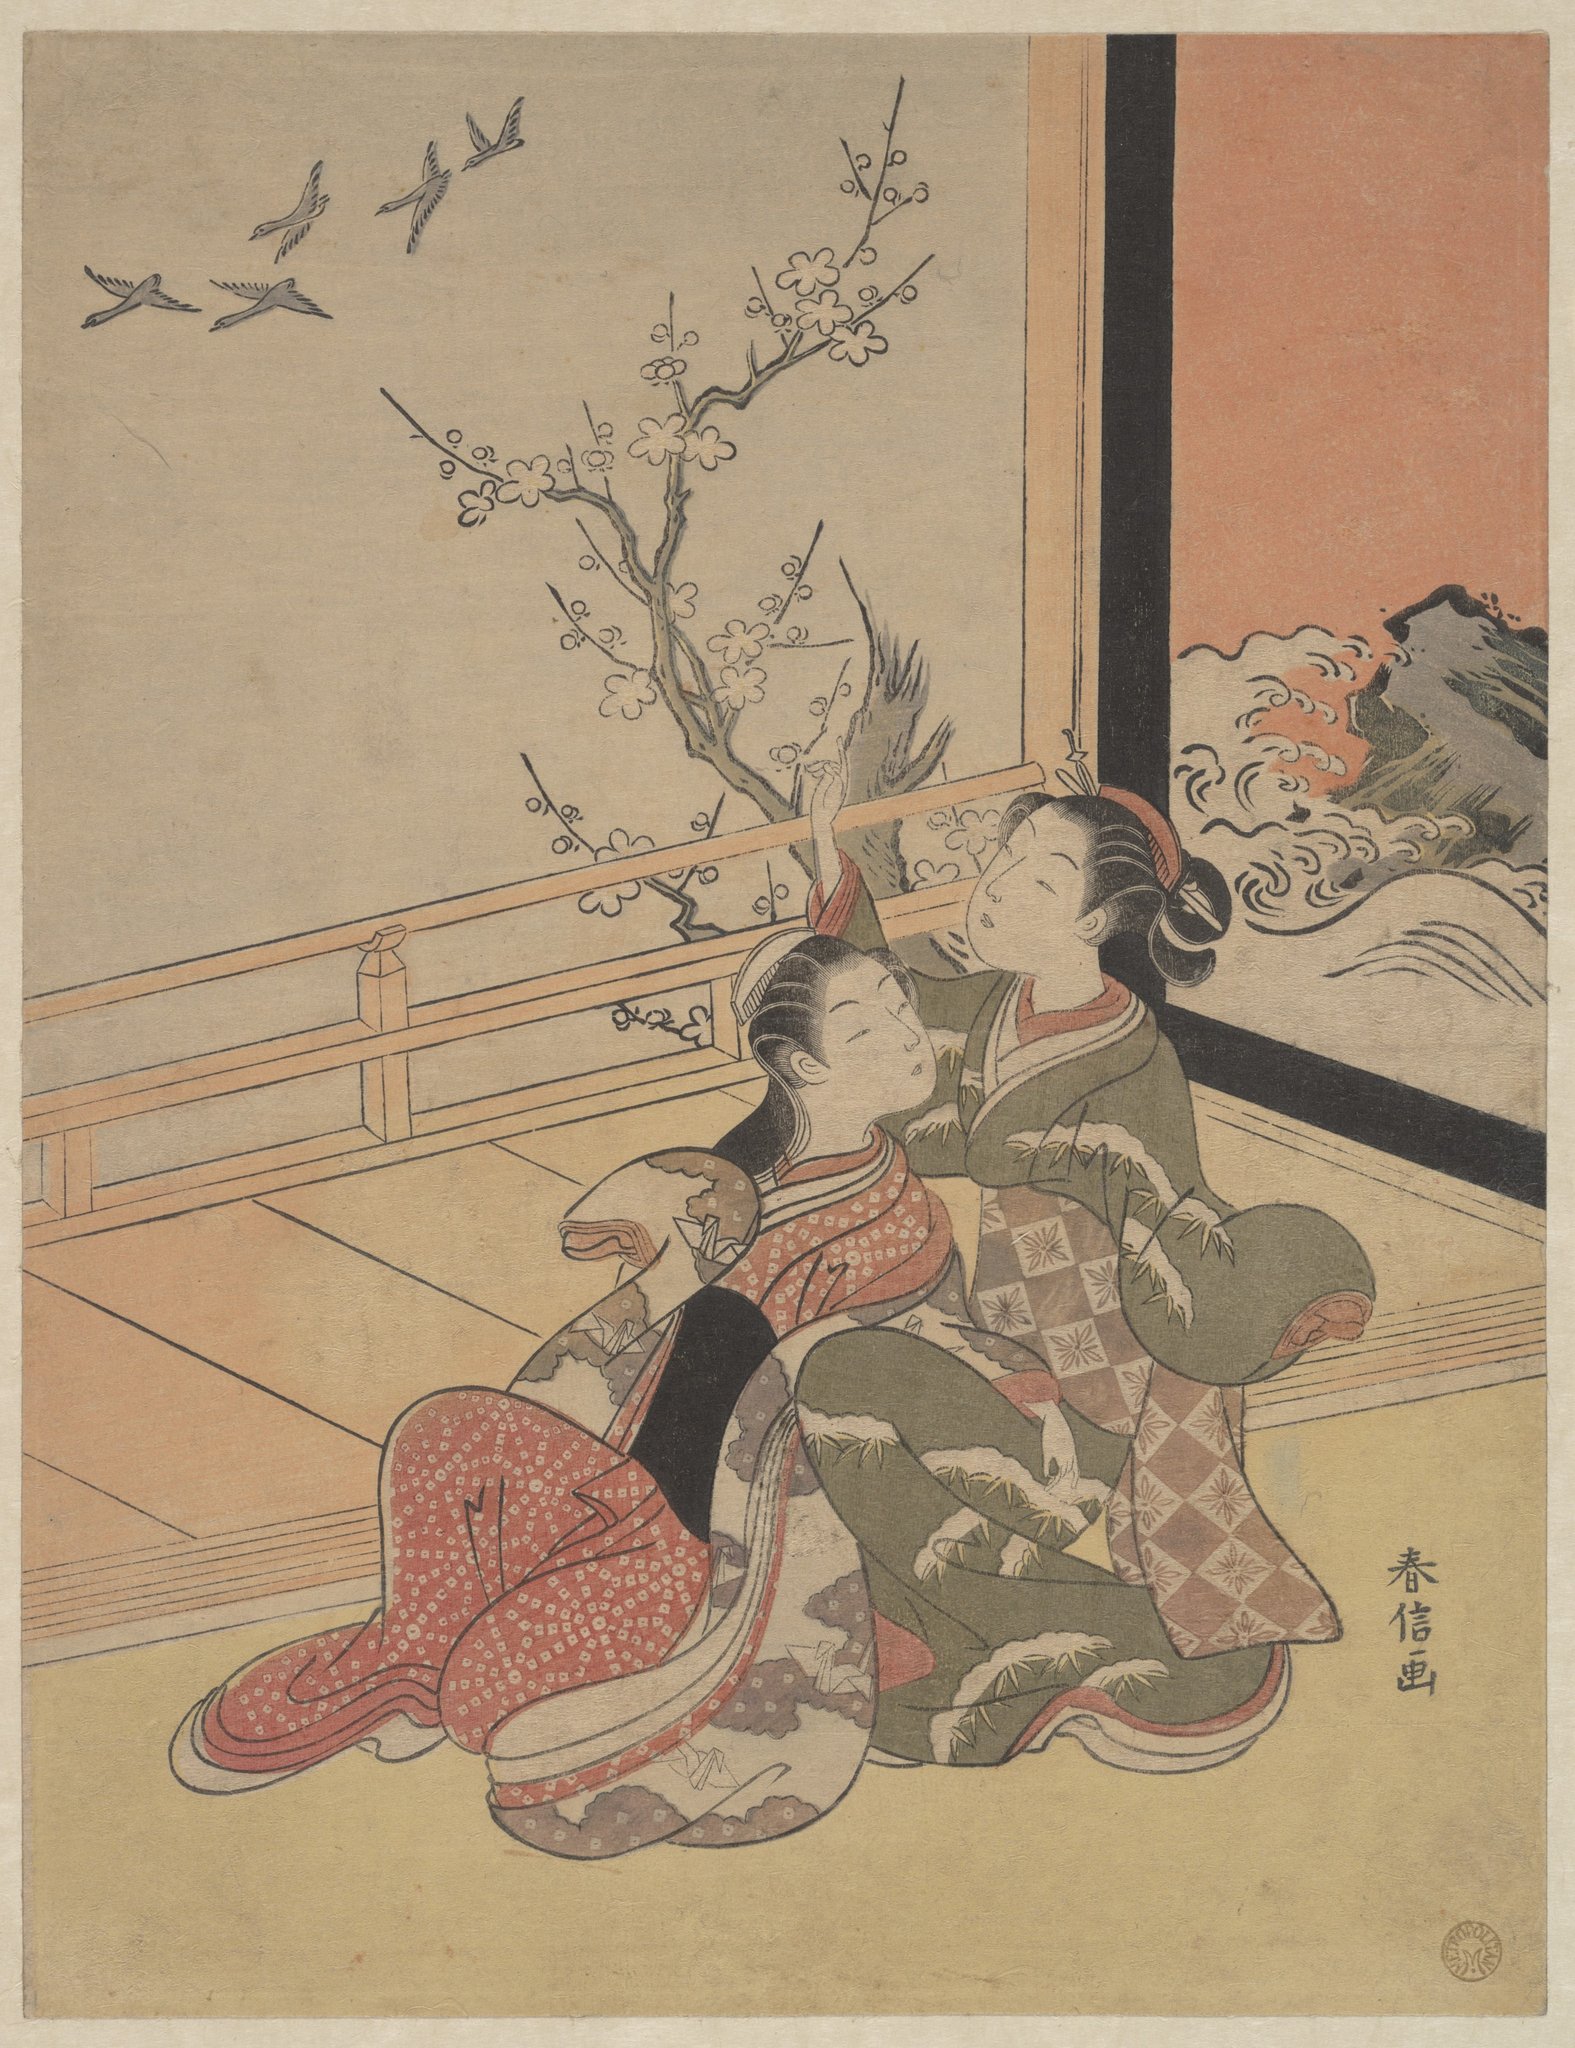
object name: print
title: See Them Fly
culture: japanese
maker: suzuki harunobu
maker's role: artist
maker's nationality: japanese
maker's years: 1725-1770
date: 1767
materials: ink, paper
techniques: woodblock print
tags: birds,women,plants